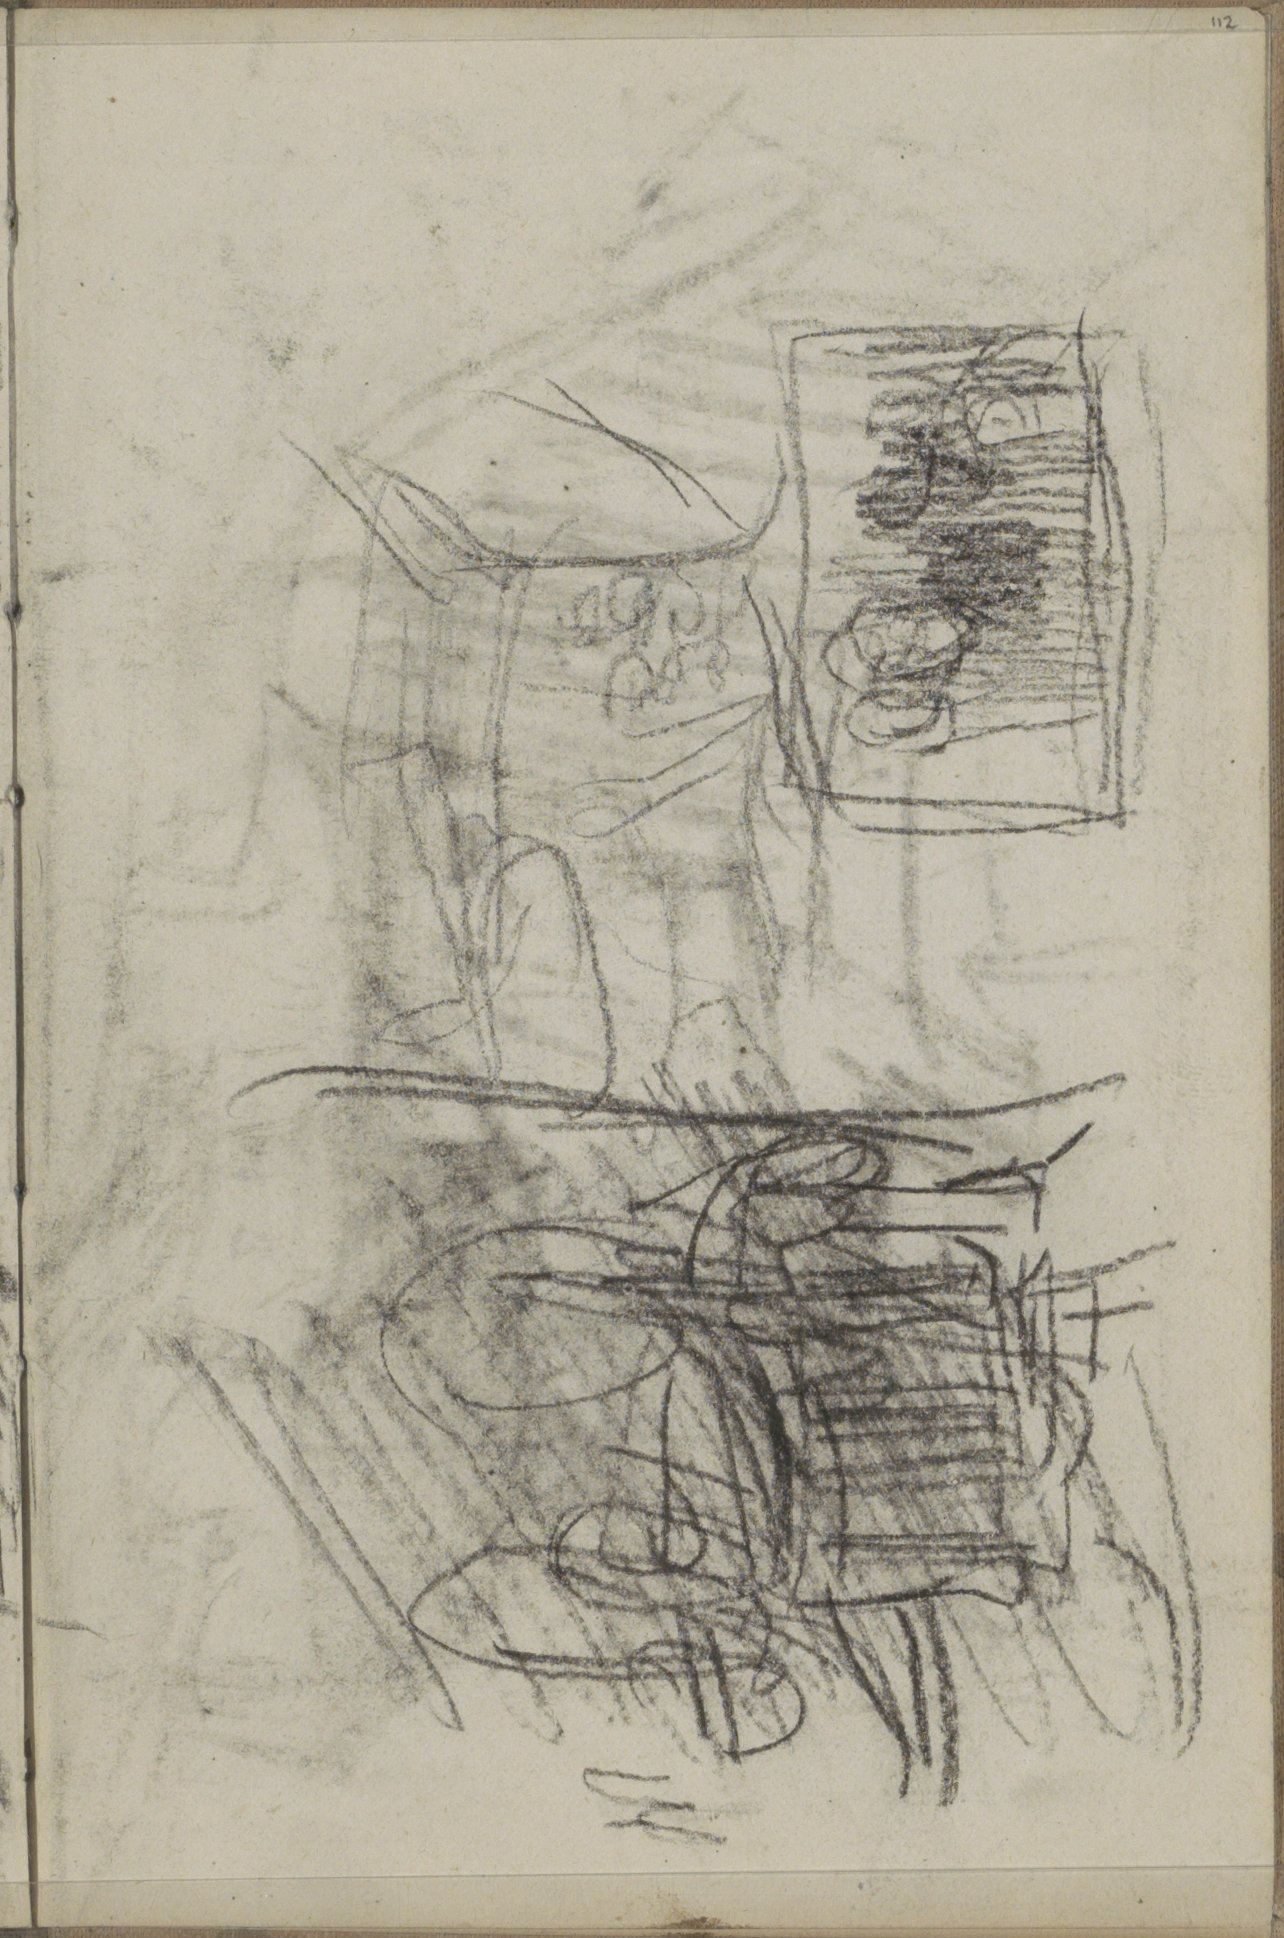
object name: sketchbook leaf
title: Studieblad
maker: marius bauer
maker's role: draughtsman, print maker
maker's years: 1867-1932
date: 1888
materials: chalk, paper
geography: istanbul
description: Pagina 112 uit een schetsboek met 56 bladen.